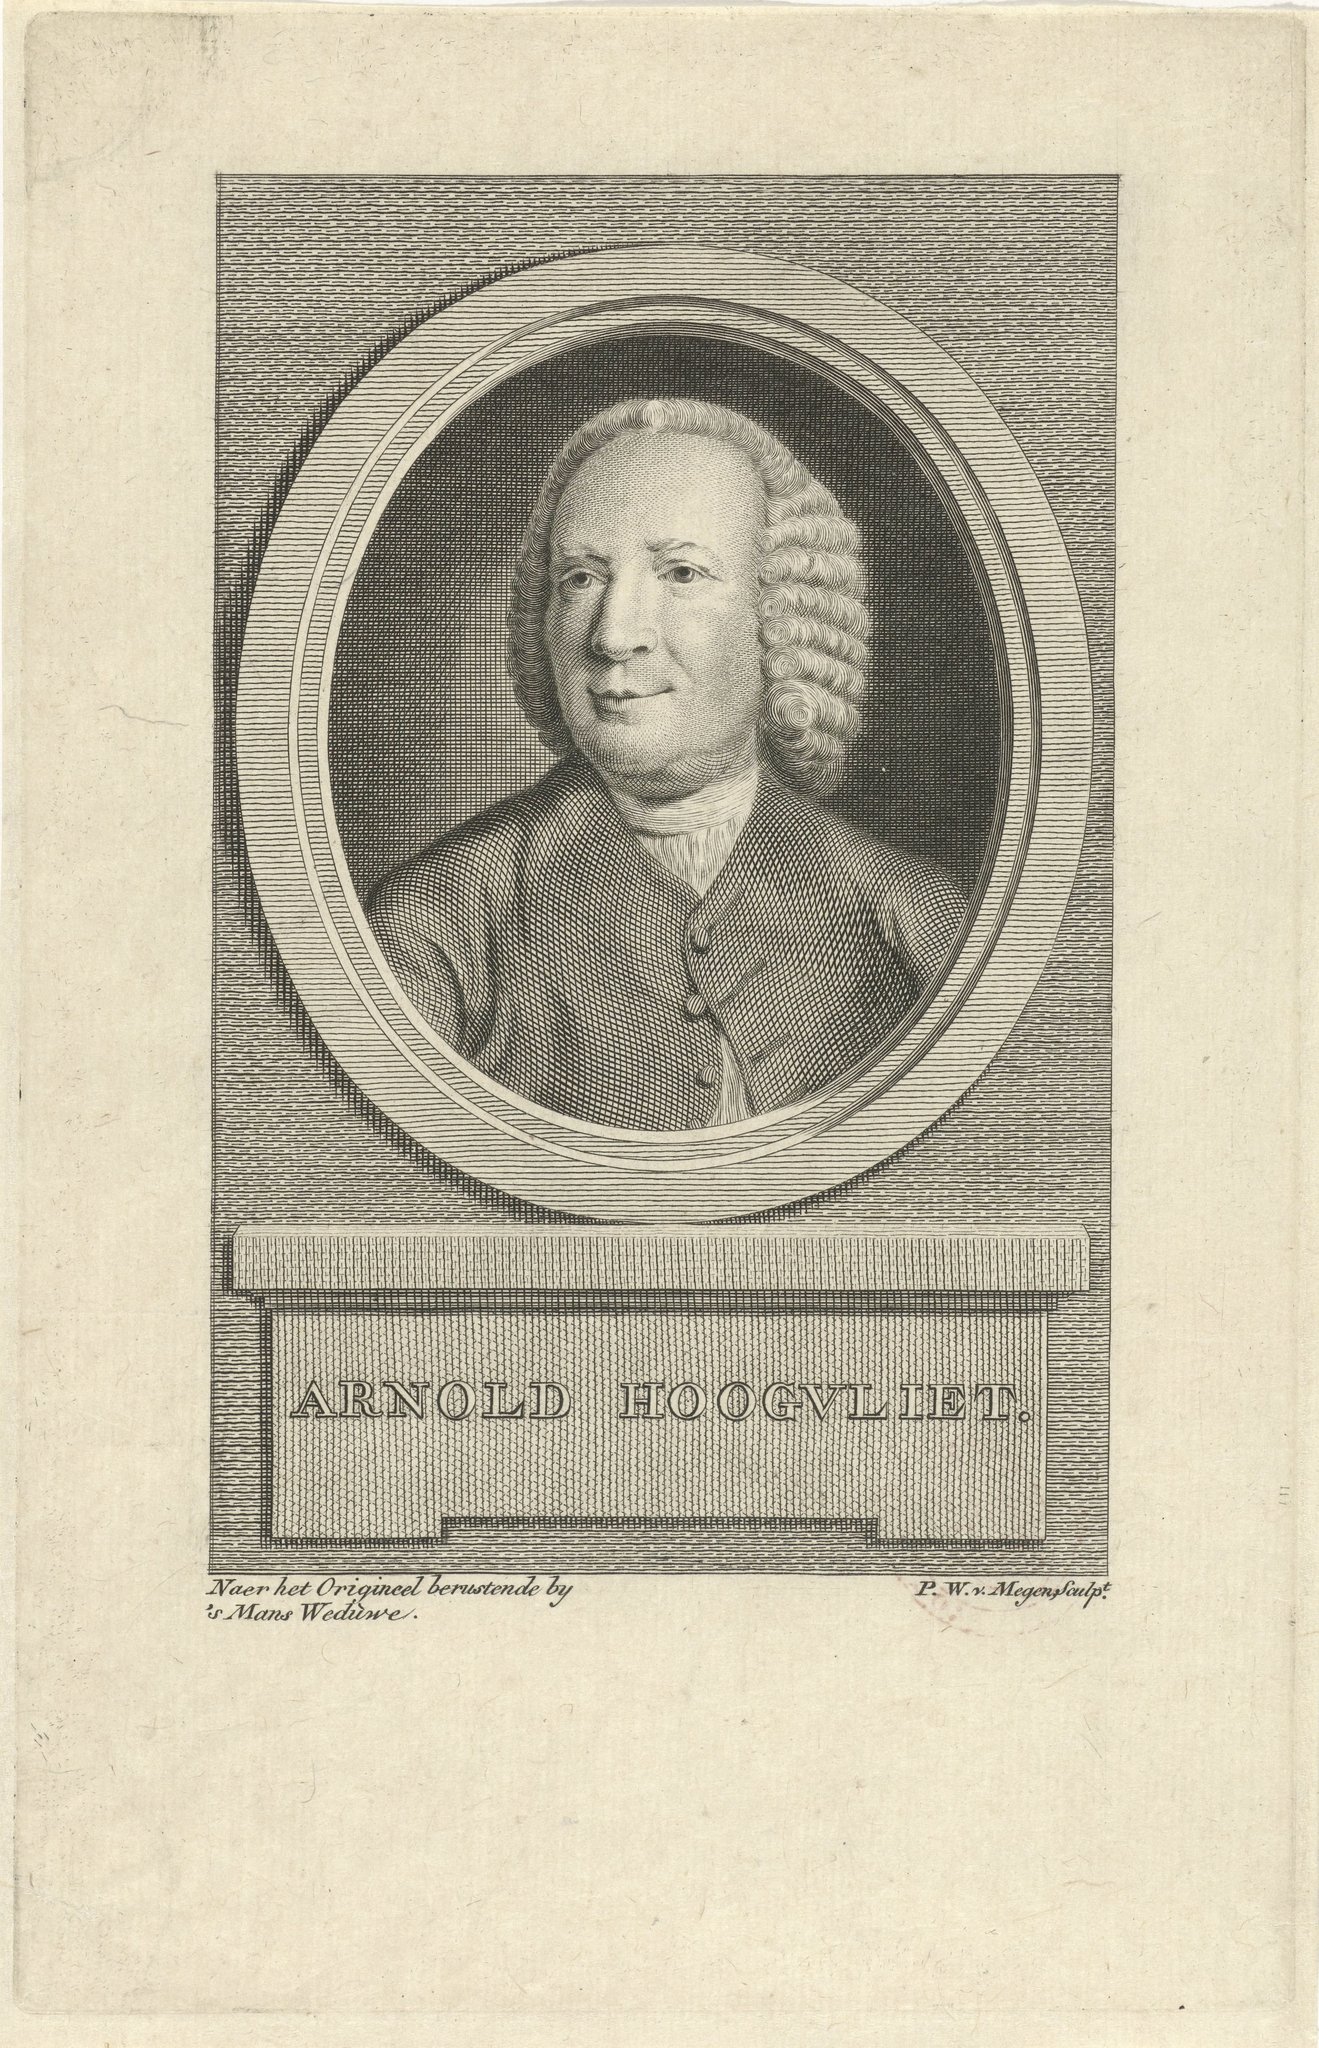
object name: print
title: Portret van Arnold Hoogvliet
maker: pieter willem van megen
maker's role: print maker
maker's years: 1750-1785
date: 1760-1785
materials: paper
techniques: engraving, etching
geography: the hague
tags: arnold hoogvliet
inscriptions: collector's mark: Lugt 240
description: Portret van de dichter Arnold Hoogvliet in een ovale lijst.